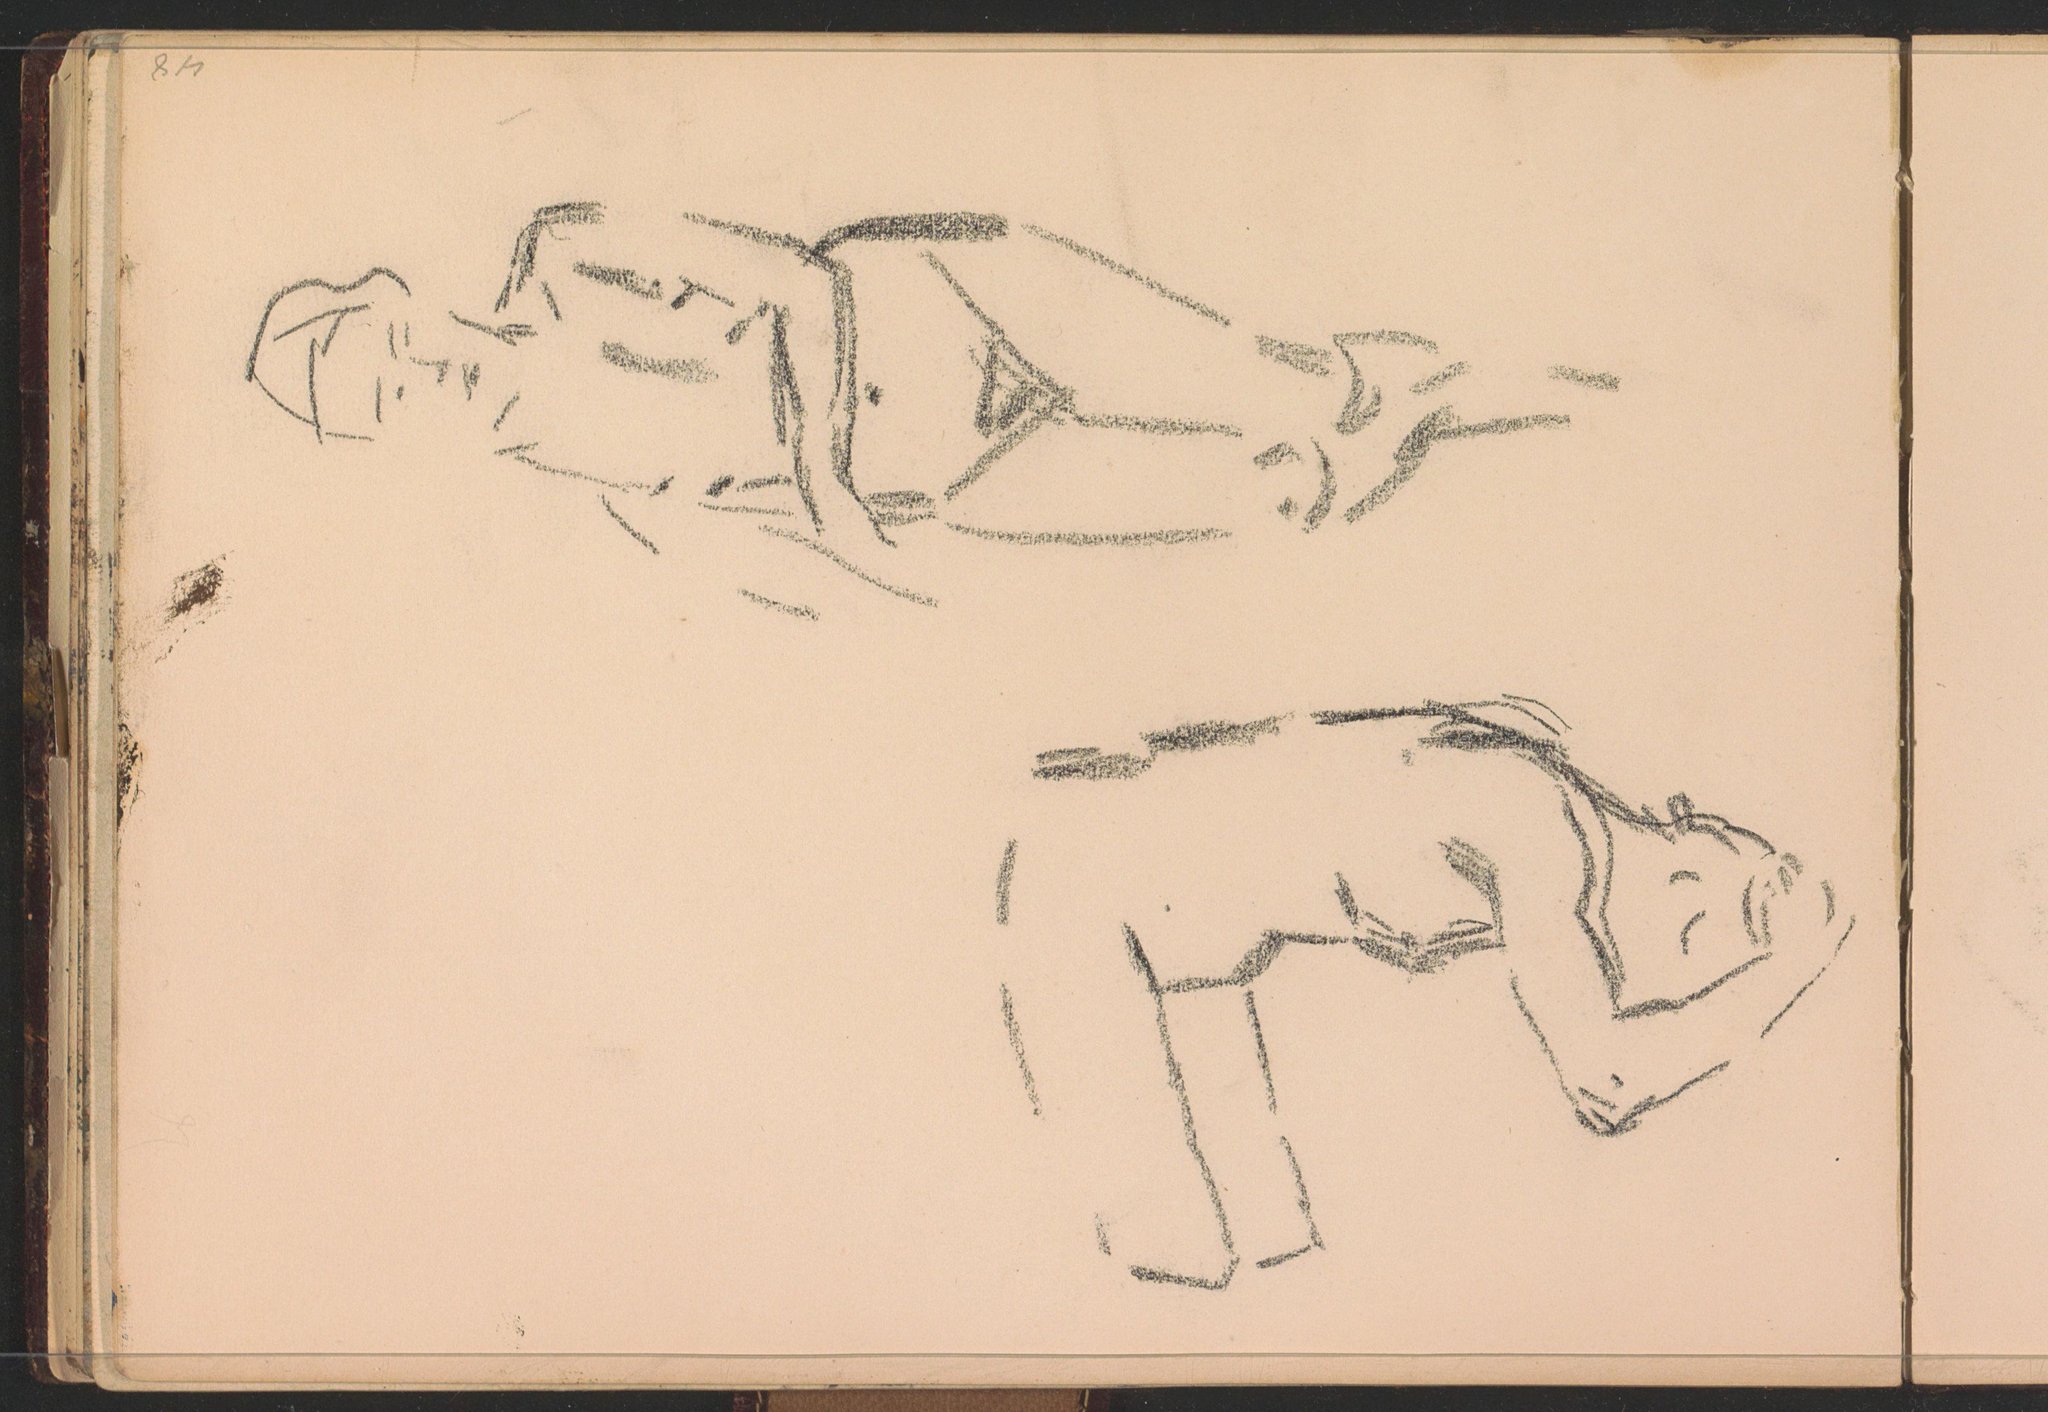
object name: sketchbook leaf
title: Zittend en liggend of staand vrouwelijk naakt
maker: isaac israels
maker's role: draughtsman, painter, print maker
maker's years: 1865-1934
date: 1890-1920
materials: chalk, paper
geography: the hague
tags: the (nude) human figure; 'corpo humano' (ripa) - aa - female human figure (+ sitting), the (nude) human figure; 'corpo humano' (ripa) - aa - female human figure (+ standing), the (nude) human figure; 'corpo humano' (ripa) - aa - female human figure (+ lying)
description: Blad 39 verso uit schetsboek X met 43 bladen.